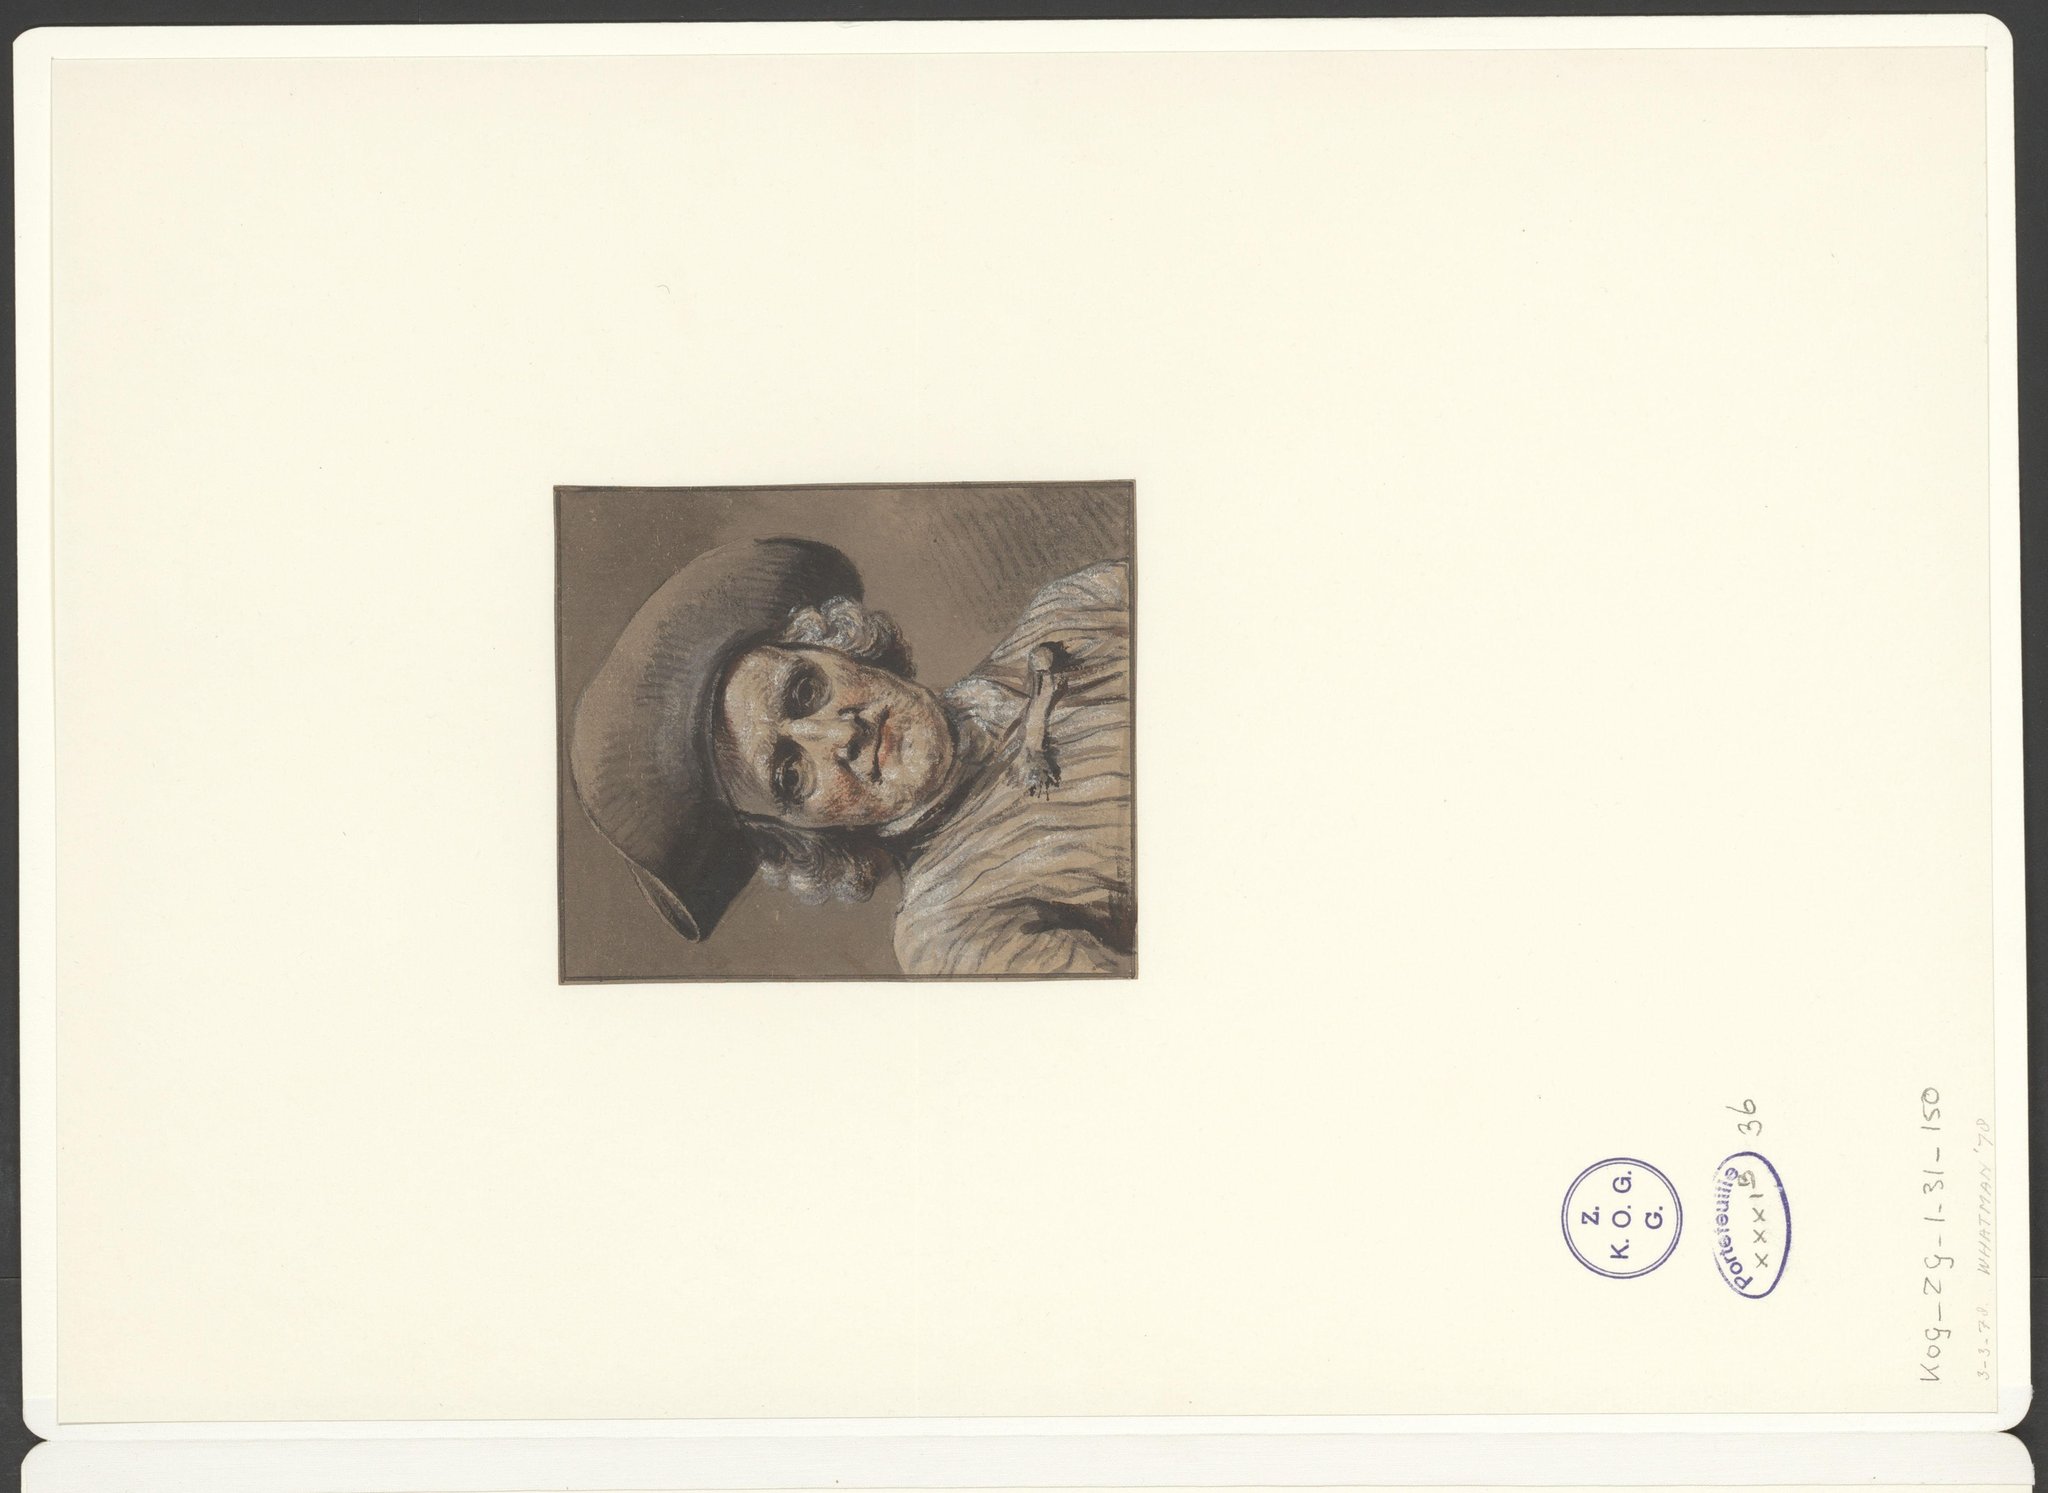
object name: drawing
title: Zelfportret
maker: jurriaan andriessen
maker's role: draughtsman, painter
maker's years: 1742-1819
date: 1772-1819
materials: chalk, ink, paper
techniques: brush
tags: amsterdam, painter, draughtsman, jurriaan andriessen, historical persons, portrait, self-portrait of painter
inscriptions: collector's mark: Lugt 1641, stamp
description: Onderwerpsrubrieken binnen de Atlas Zeden en Gewoonten: Portretten, Portretten van bijzondere personen.